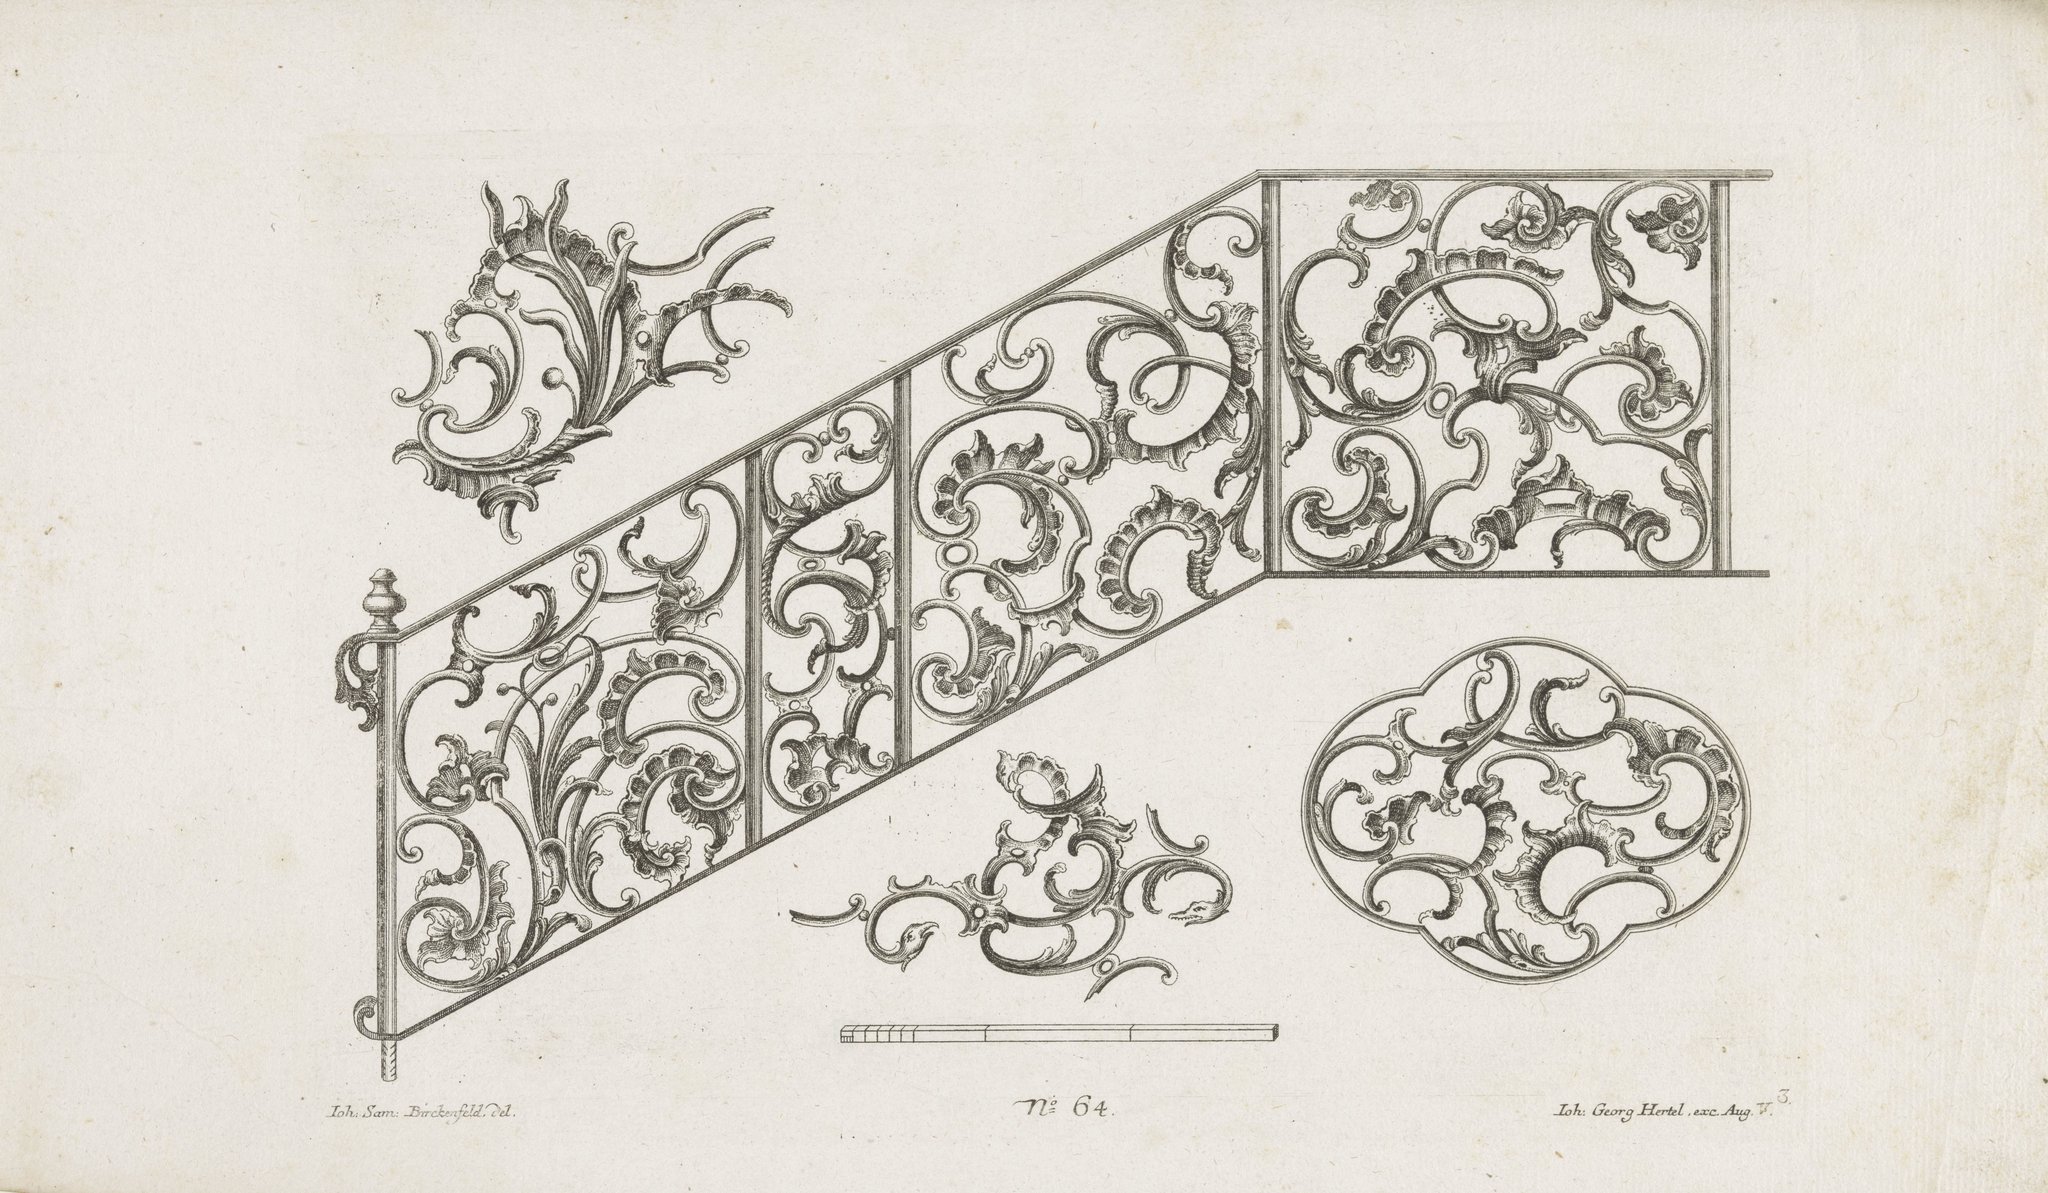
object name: ornament print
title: Ontwerpen voor smeedijzeren sierhekken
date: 1750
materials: paper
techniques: etching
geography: augsburg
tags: rocaille ornament, forging (industrial process) (+ product ~ crafts, industries, agriculture), fence, wall, paling, other ornament derived from animal forms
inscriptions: collector's mark: Lugt 2228, collector's mark: Lugt 2760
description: Onder een ornament met vogelkoppen. Midden onder 64 genummerd.